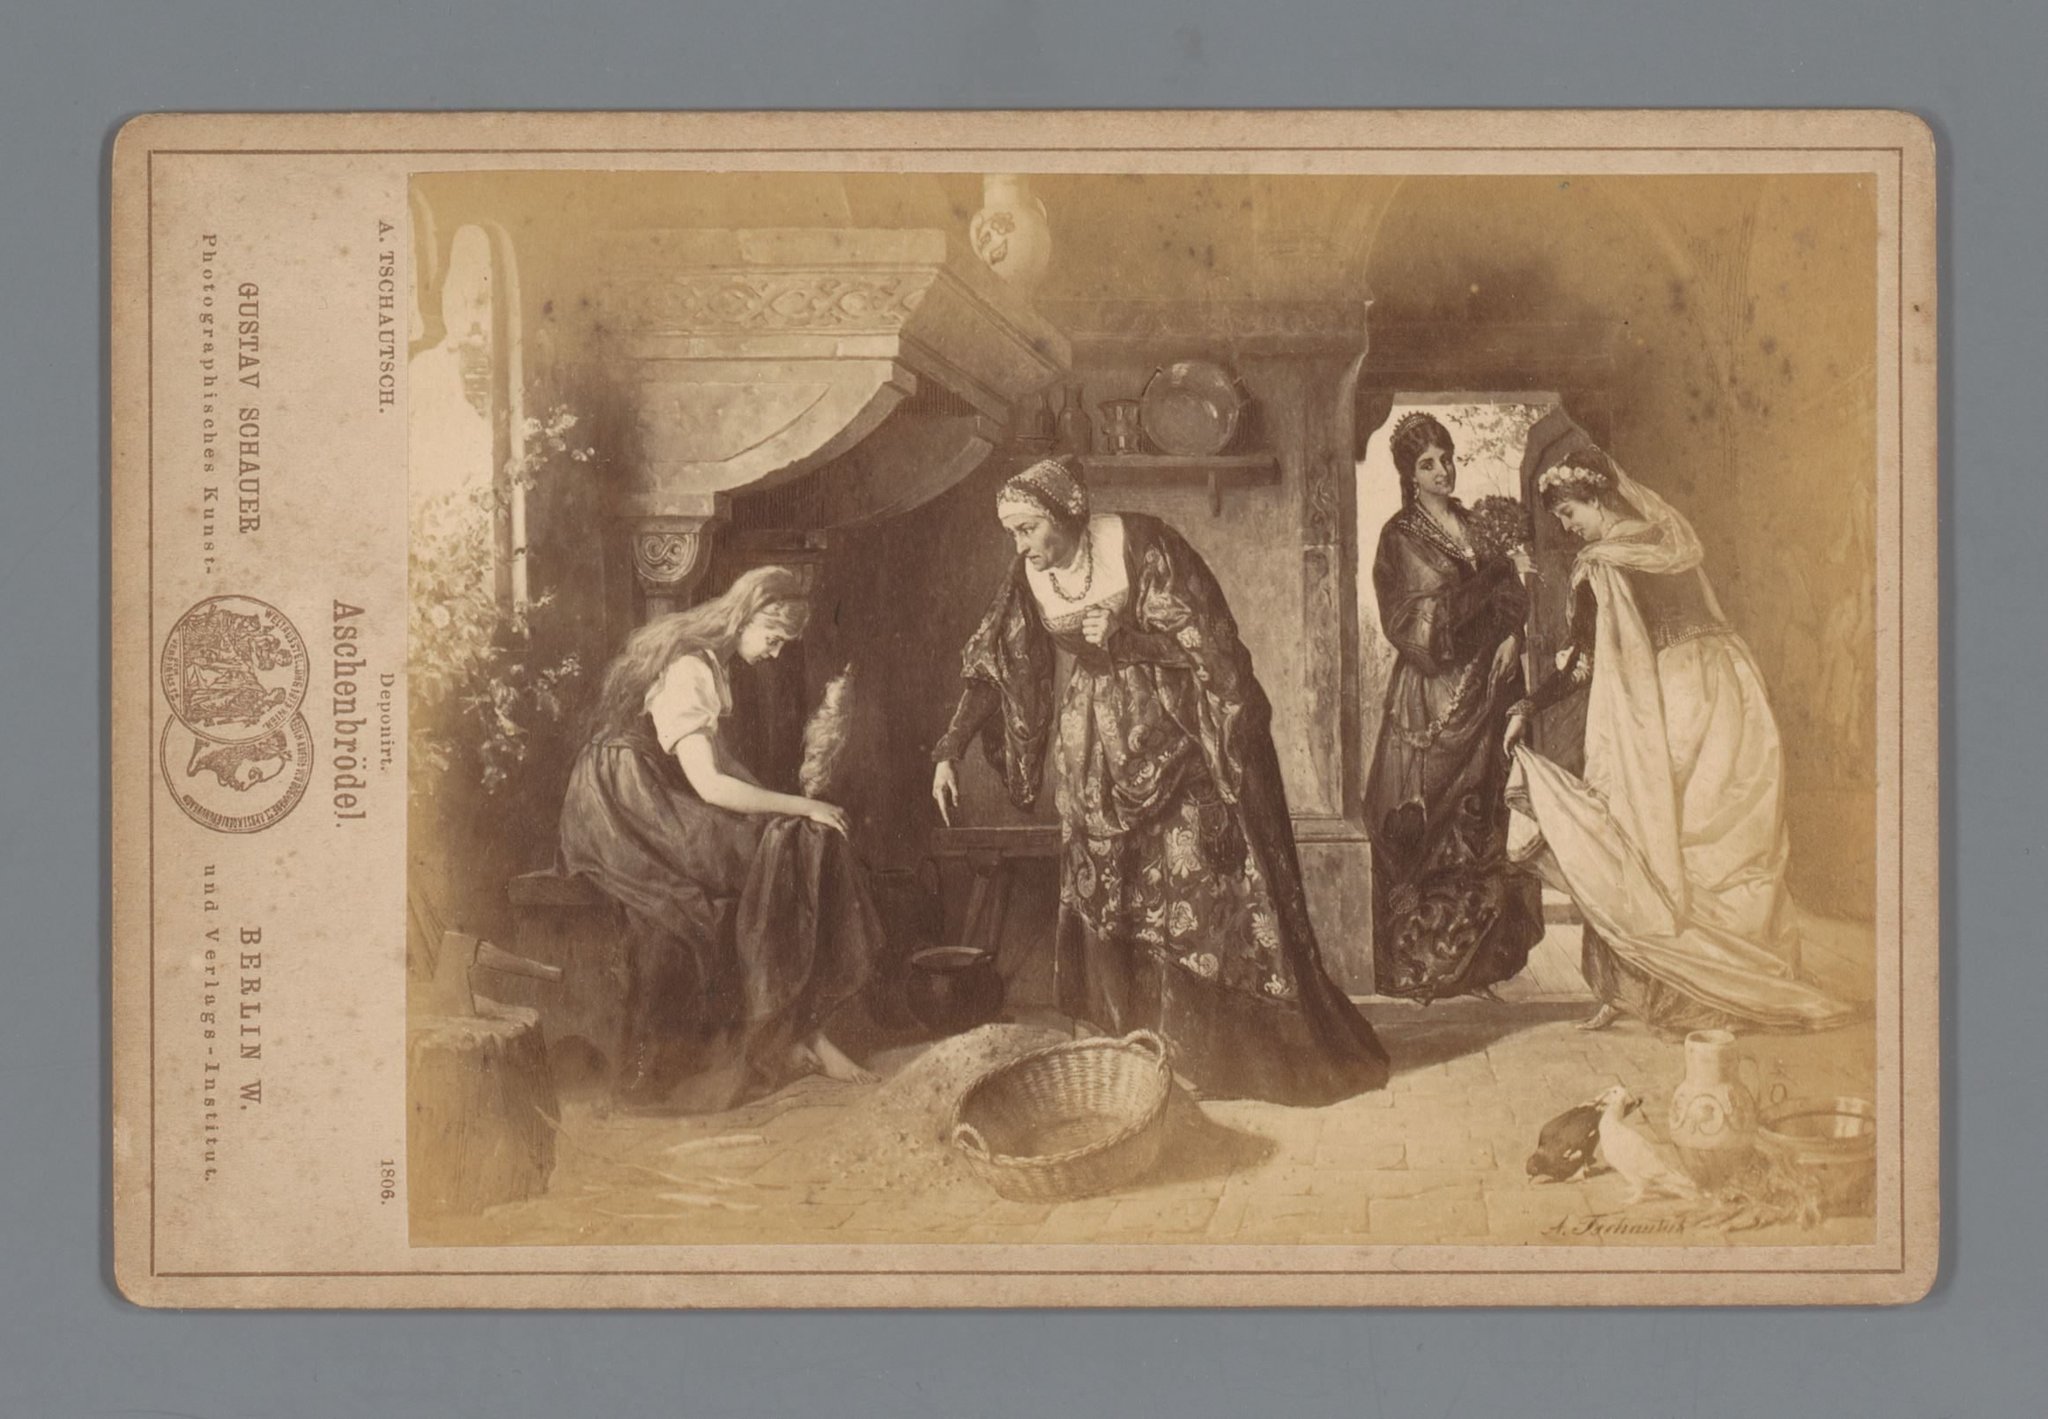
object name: cabinet photograph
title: Fotoreproductie van een schilderij, voorstellende Assepoester met haar stiefmoeder en stiefzussen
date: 1875-1890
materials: cardboard, photographic support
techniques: albumen print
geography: berlin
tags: tales and fairy tales (with title)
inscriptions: number: ‘1806.’